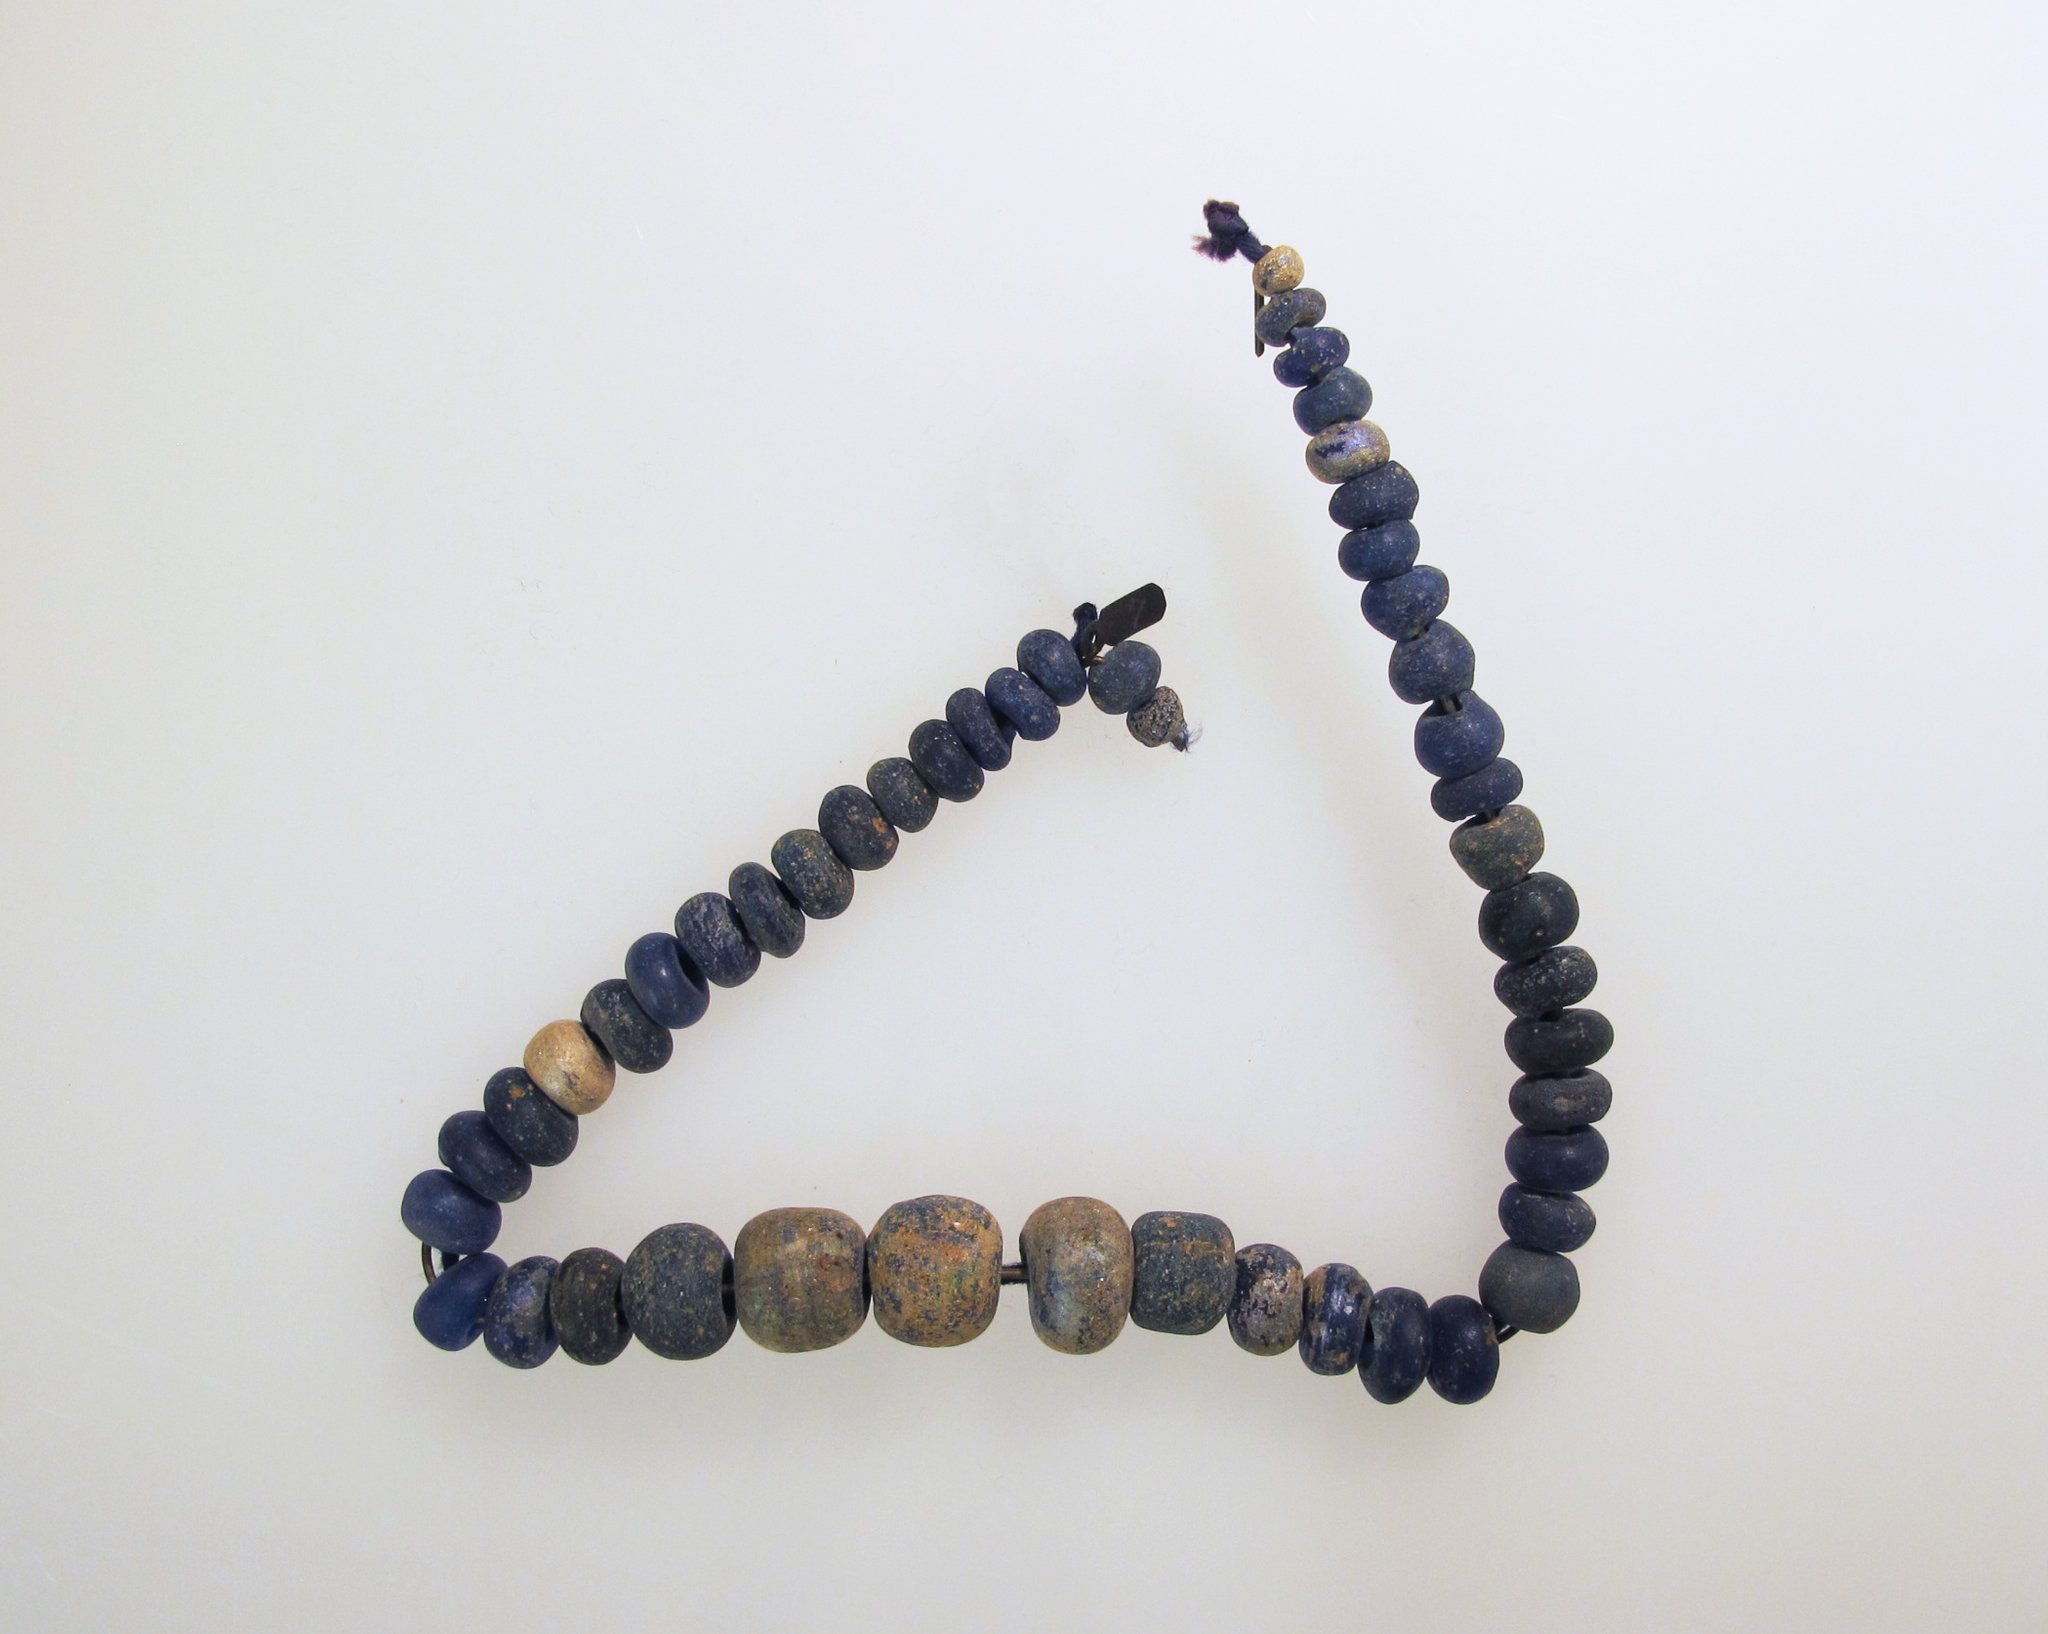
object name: bead, 51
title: Beads, 51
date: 7000 BCE-330 CE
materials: glass